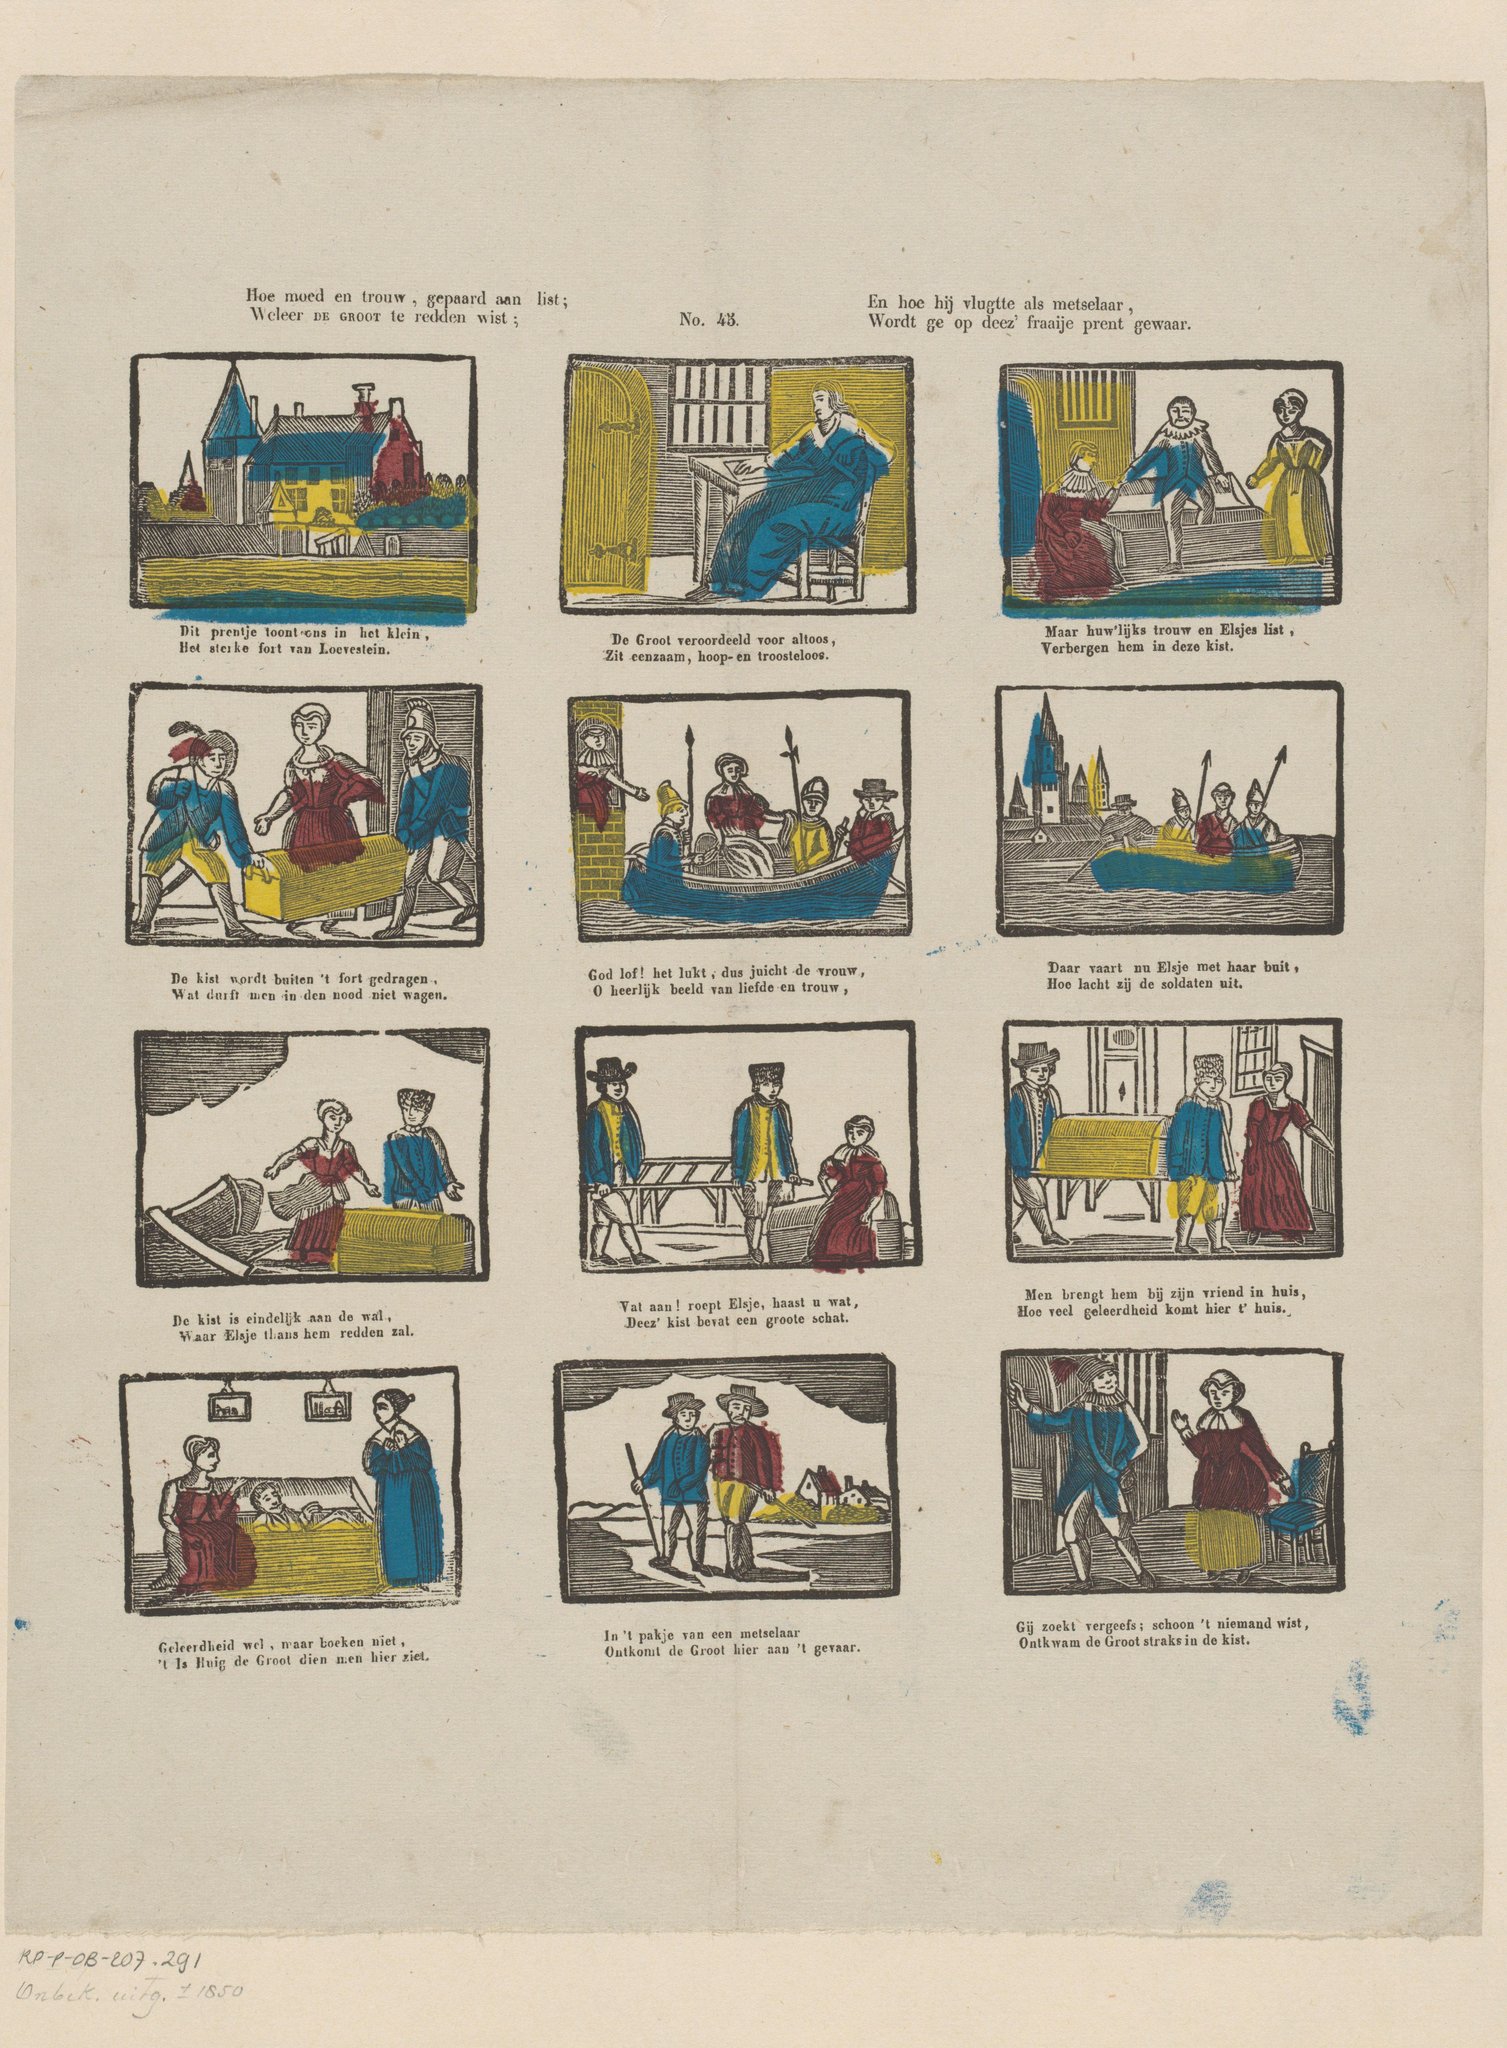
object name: print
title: Hoe moed en trouw gepaard aan list; / Weleer De Groot te redden wist. / En hoe hij vluchtte als metselaar. / Wordt ge op deez' fraaije prent gewaar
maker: Anonymous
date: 1848-1881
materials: paper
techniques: colour, letterpress printing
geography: den bosch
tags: delft, hugo de groot, history, loevestein castle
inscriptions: collector's mark: Lugt 2760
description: Blad met 12 voorstellingen over de ontsnapping van Hugo de Groot uit Slot Loevestein verstopt in een boekenkist, op 22 maart 1621. Onder elke afbeelding een tweeregelig vers. Genummerd midden boven: No. 45.